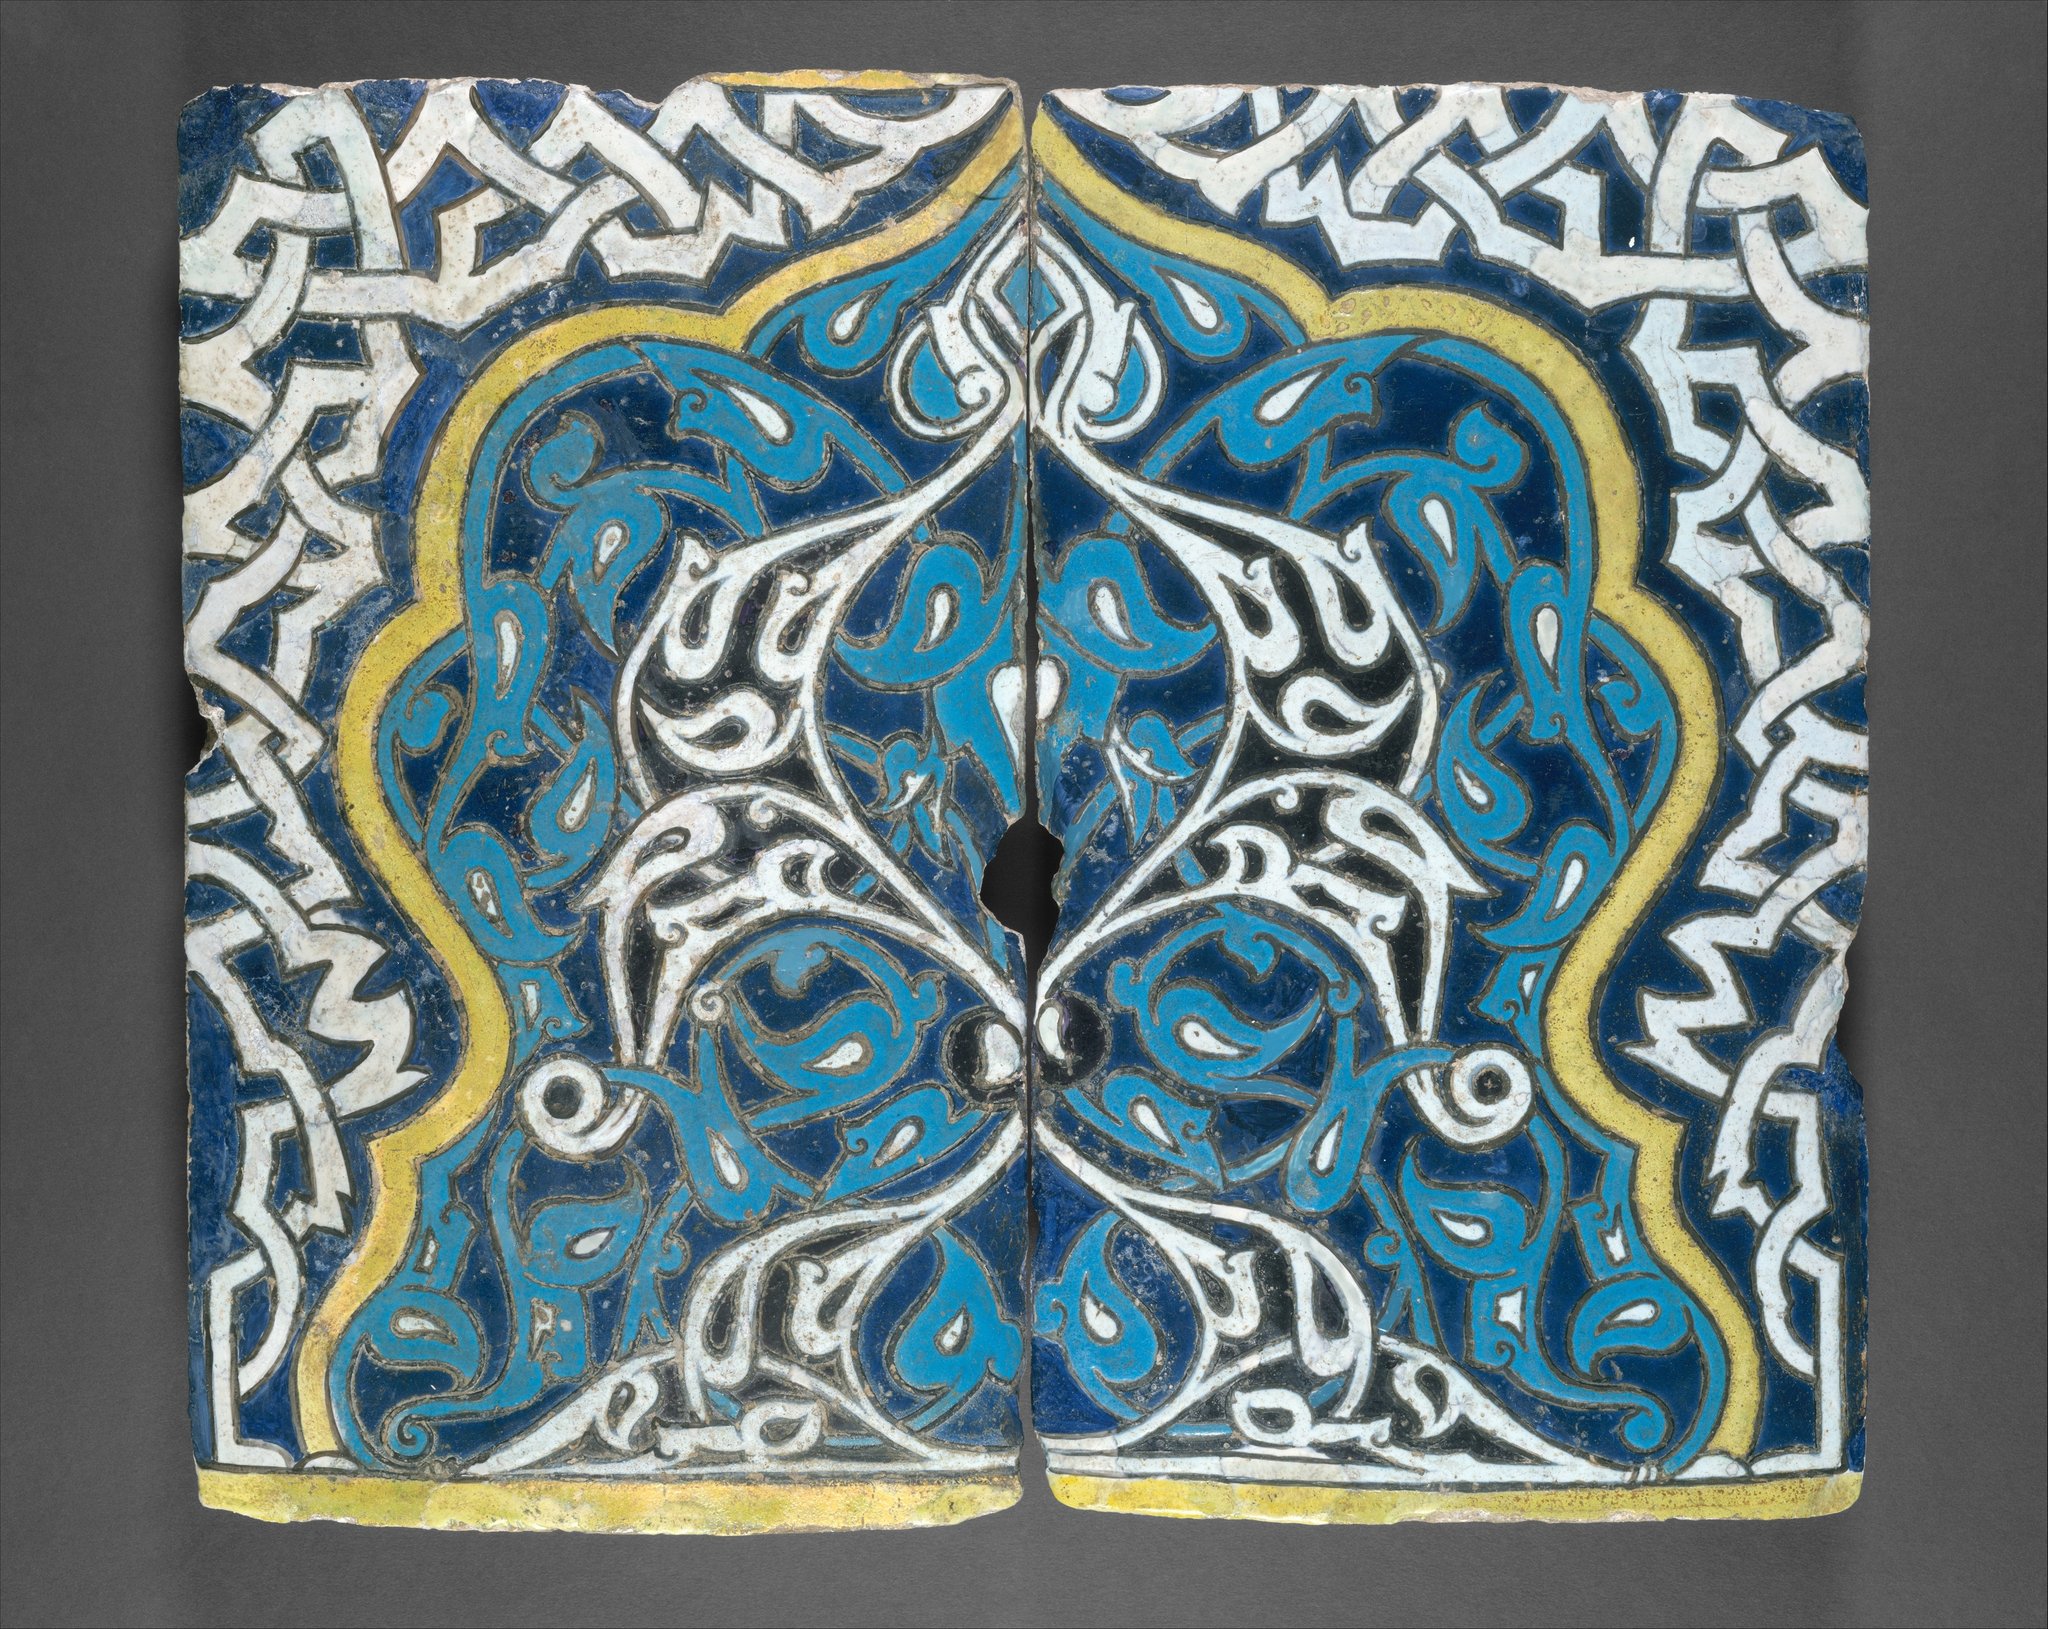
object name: tile fragment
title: Shaped Tiles in the 'Cuerda Seca' Technique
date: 1367-1400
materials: glaze, stonepaste, wax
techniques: polychrome, resist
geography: turkey